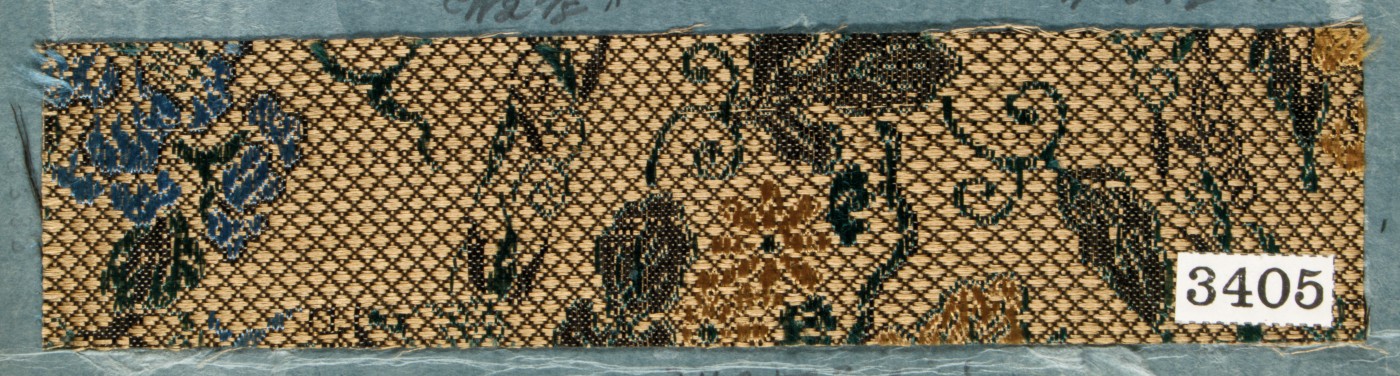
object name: textile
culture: japanese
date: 1801-1900